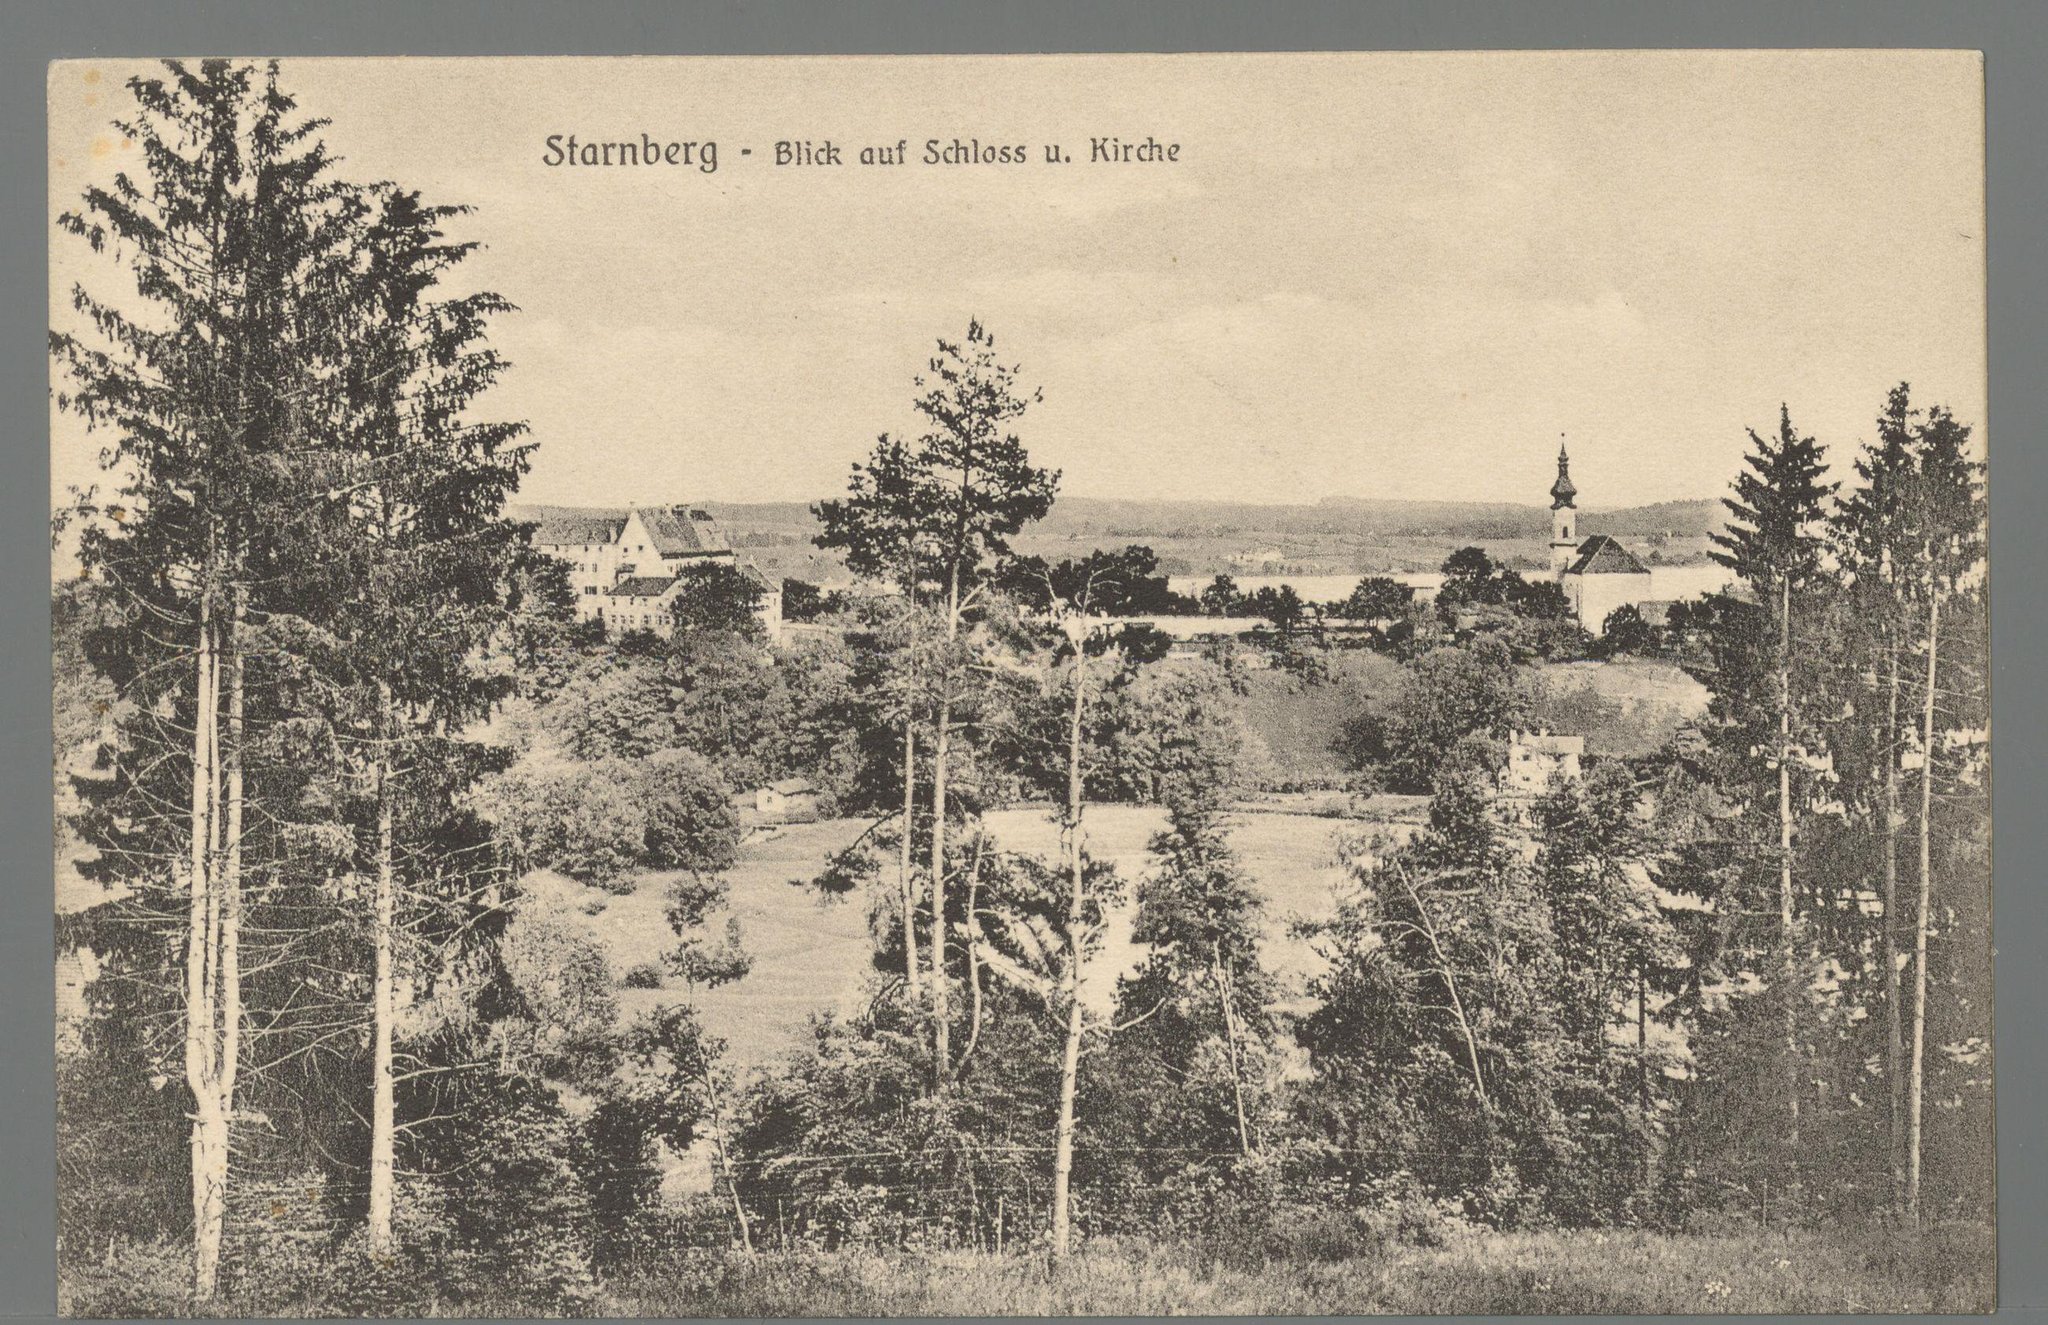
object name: ansichtkaart, prentbriefkaart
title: Starnberg - Blick auf Schloss u. Kirche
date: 1905-1909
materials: cardboard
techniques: photograph, writing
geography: starnberg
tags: castle, church (exterior)